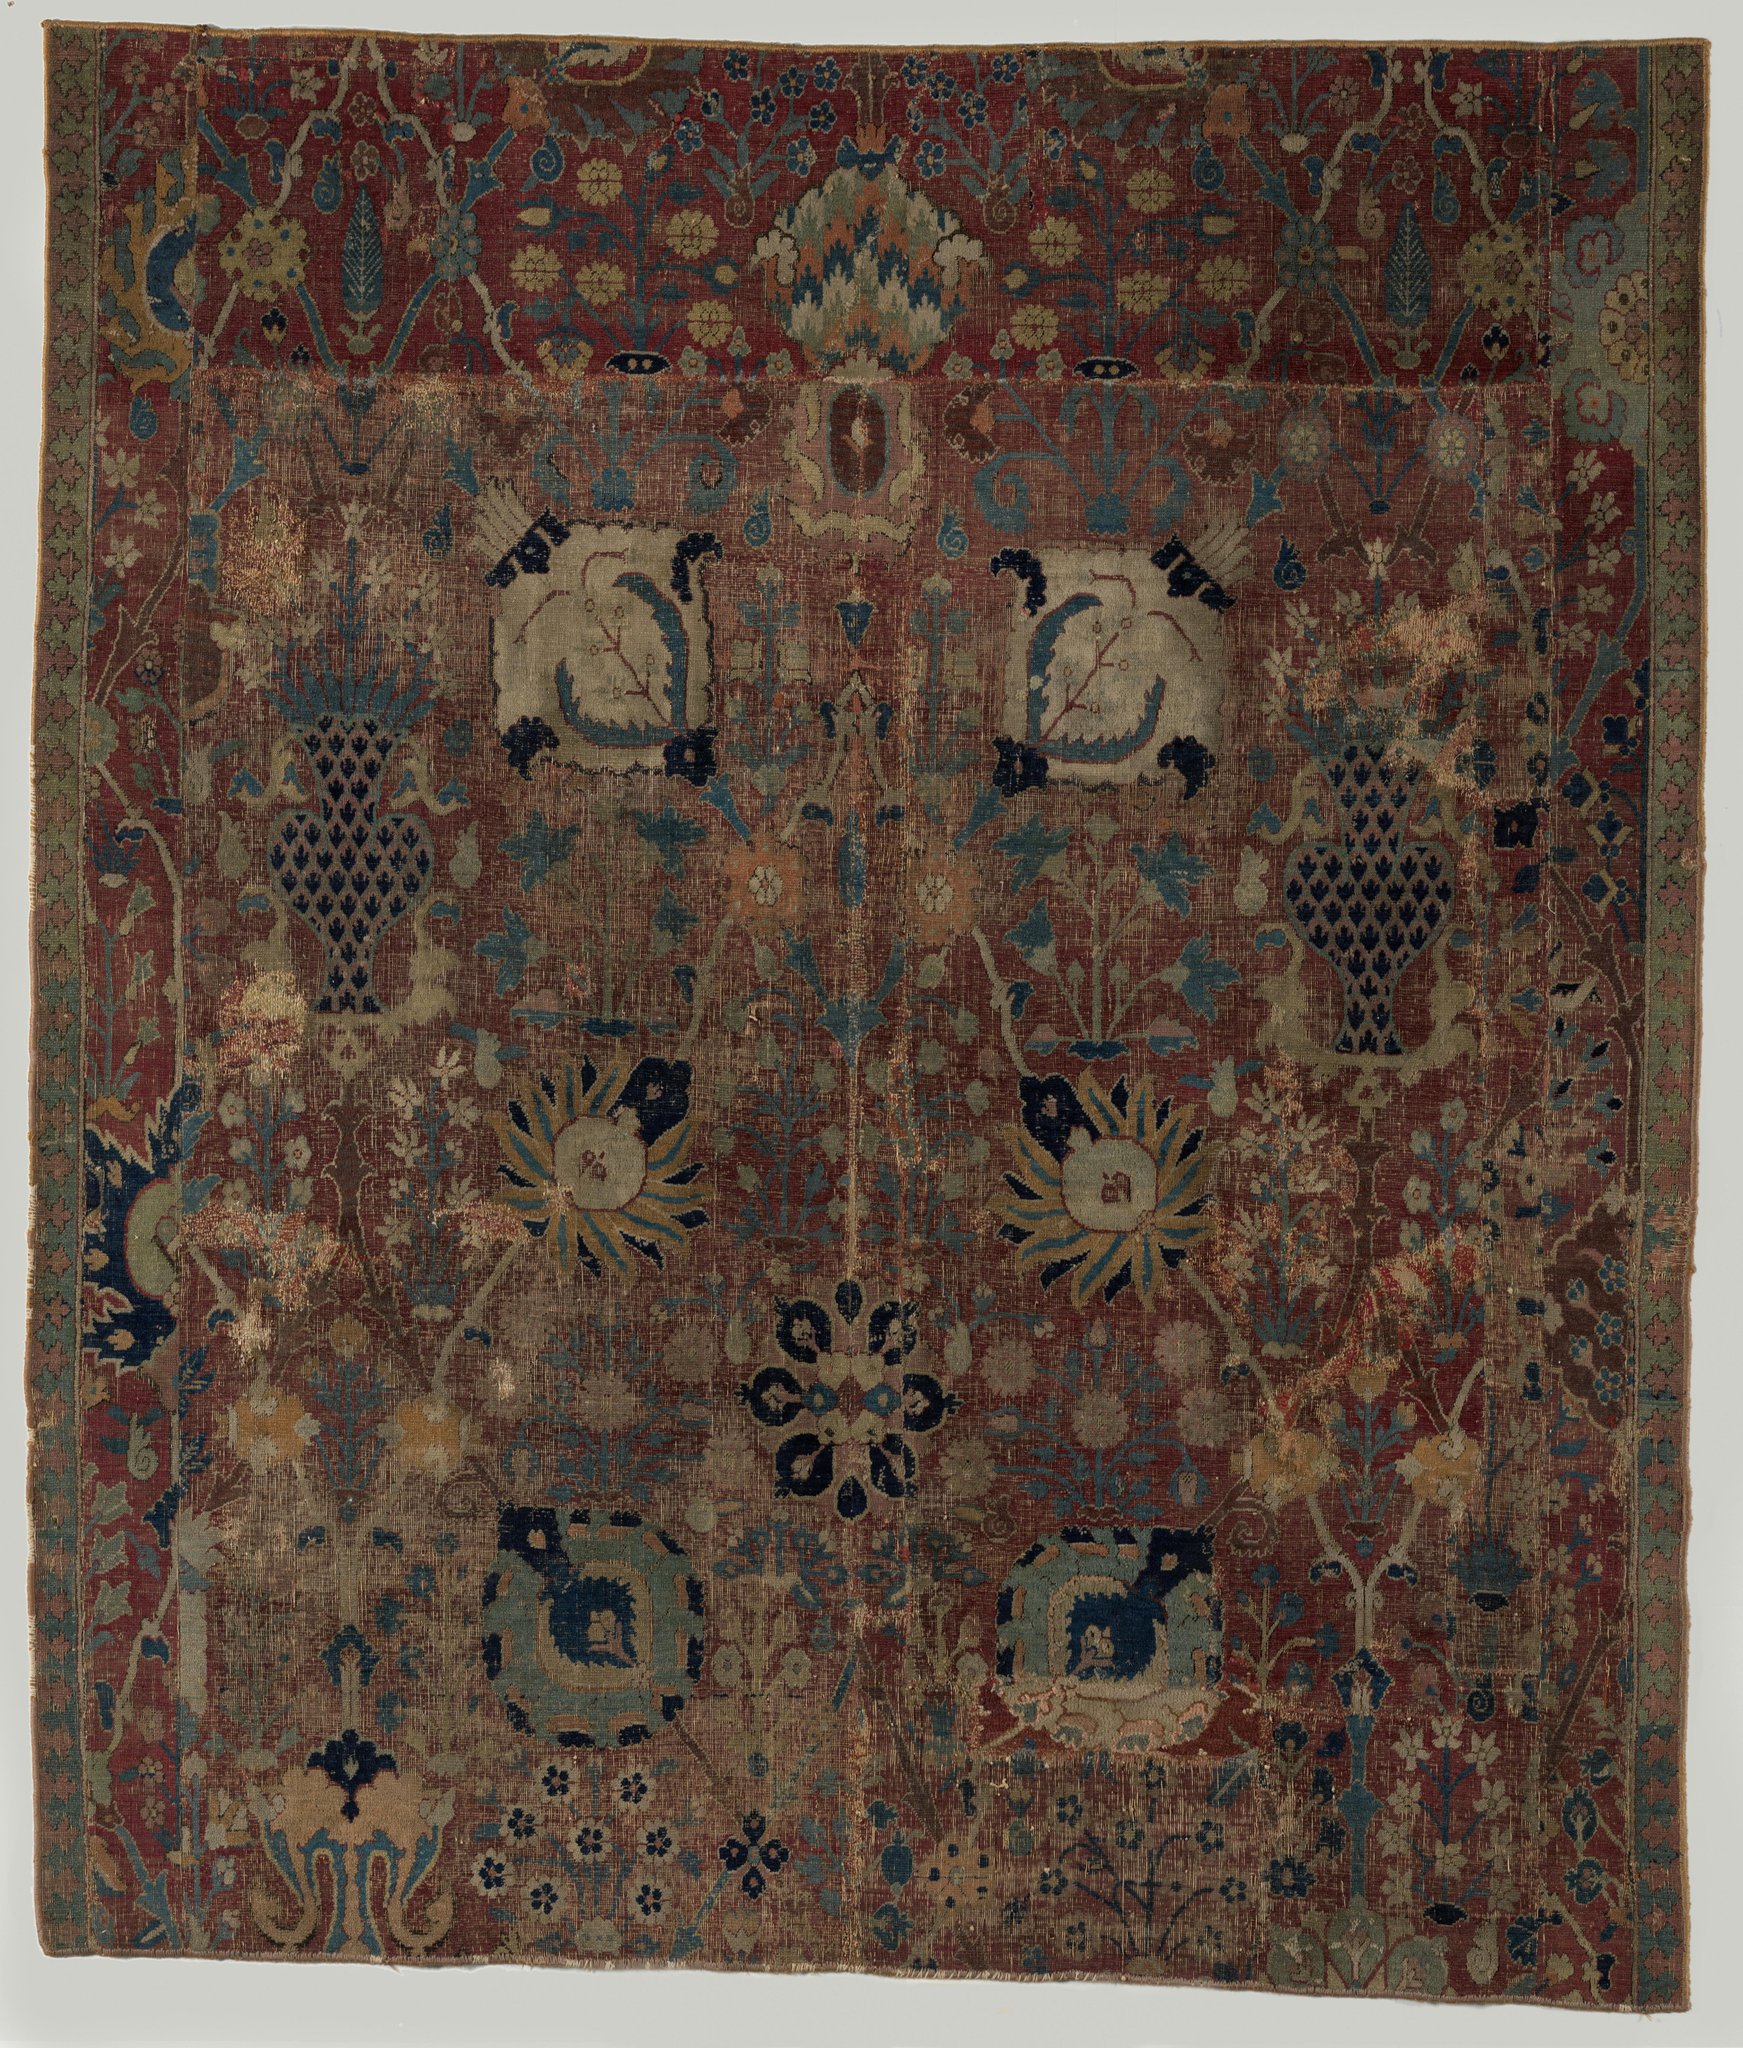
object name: oriental rug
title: Fragment van oosters tapijt: middenveld met lotusbloemen en rozetten en vazen.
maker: Anonymous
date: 1600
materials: wool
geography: south persia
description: Fragment van een oosters tapijt, bloemen en vazenkleed. In het middenveld ranken die lotusbloemen, rozetten en vazen dragen. Het veld wordt gevuld met plantmotieven.